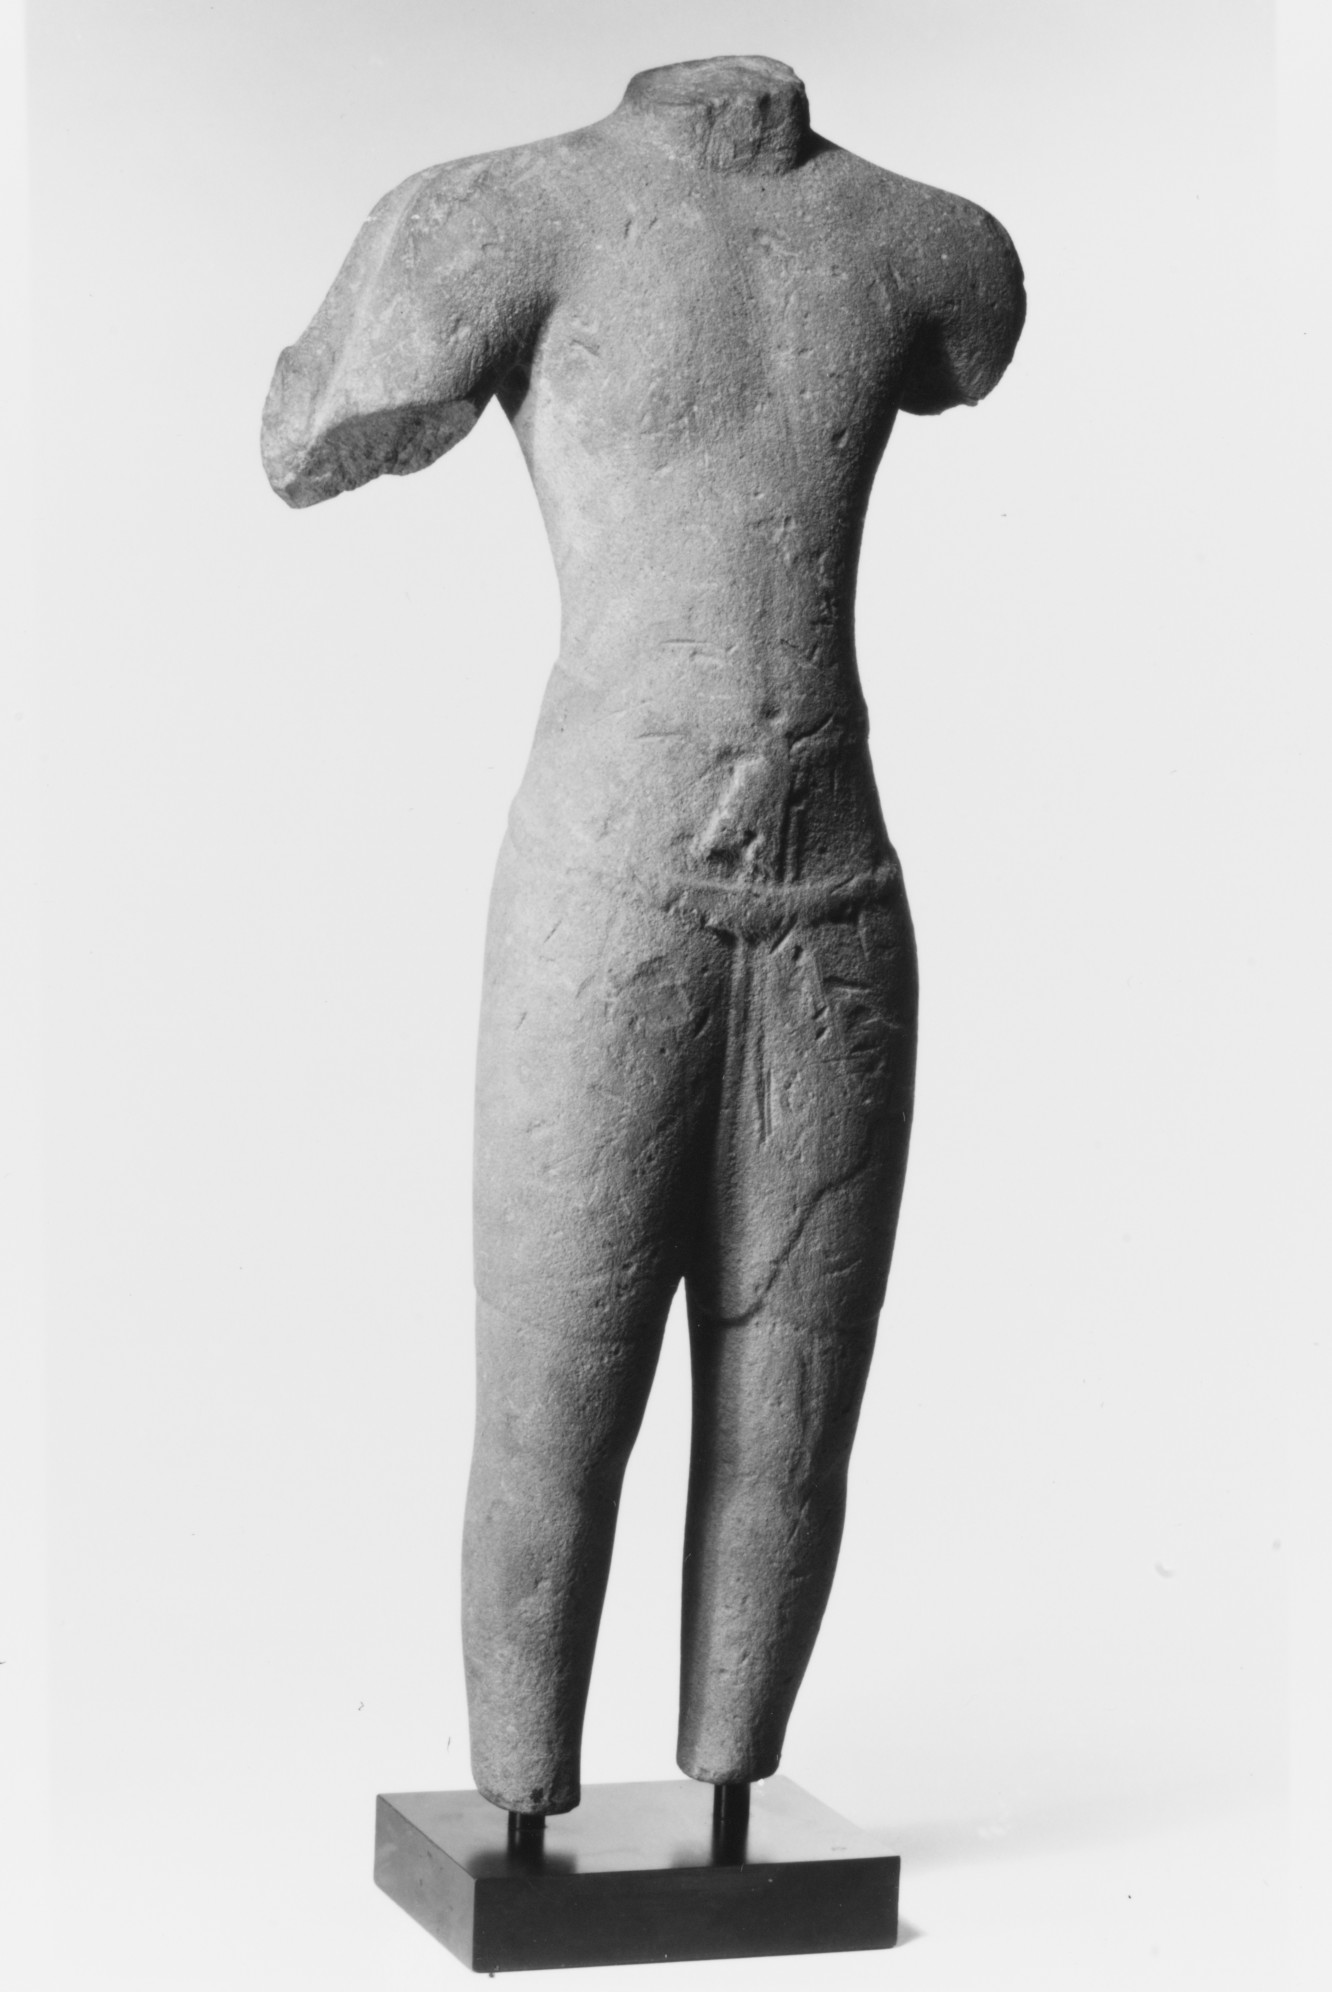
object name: figure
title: Standing Four-Armed Deity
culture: cambodian or vietnamese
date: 601-700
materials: stone